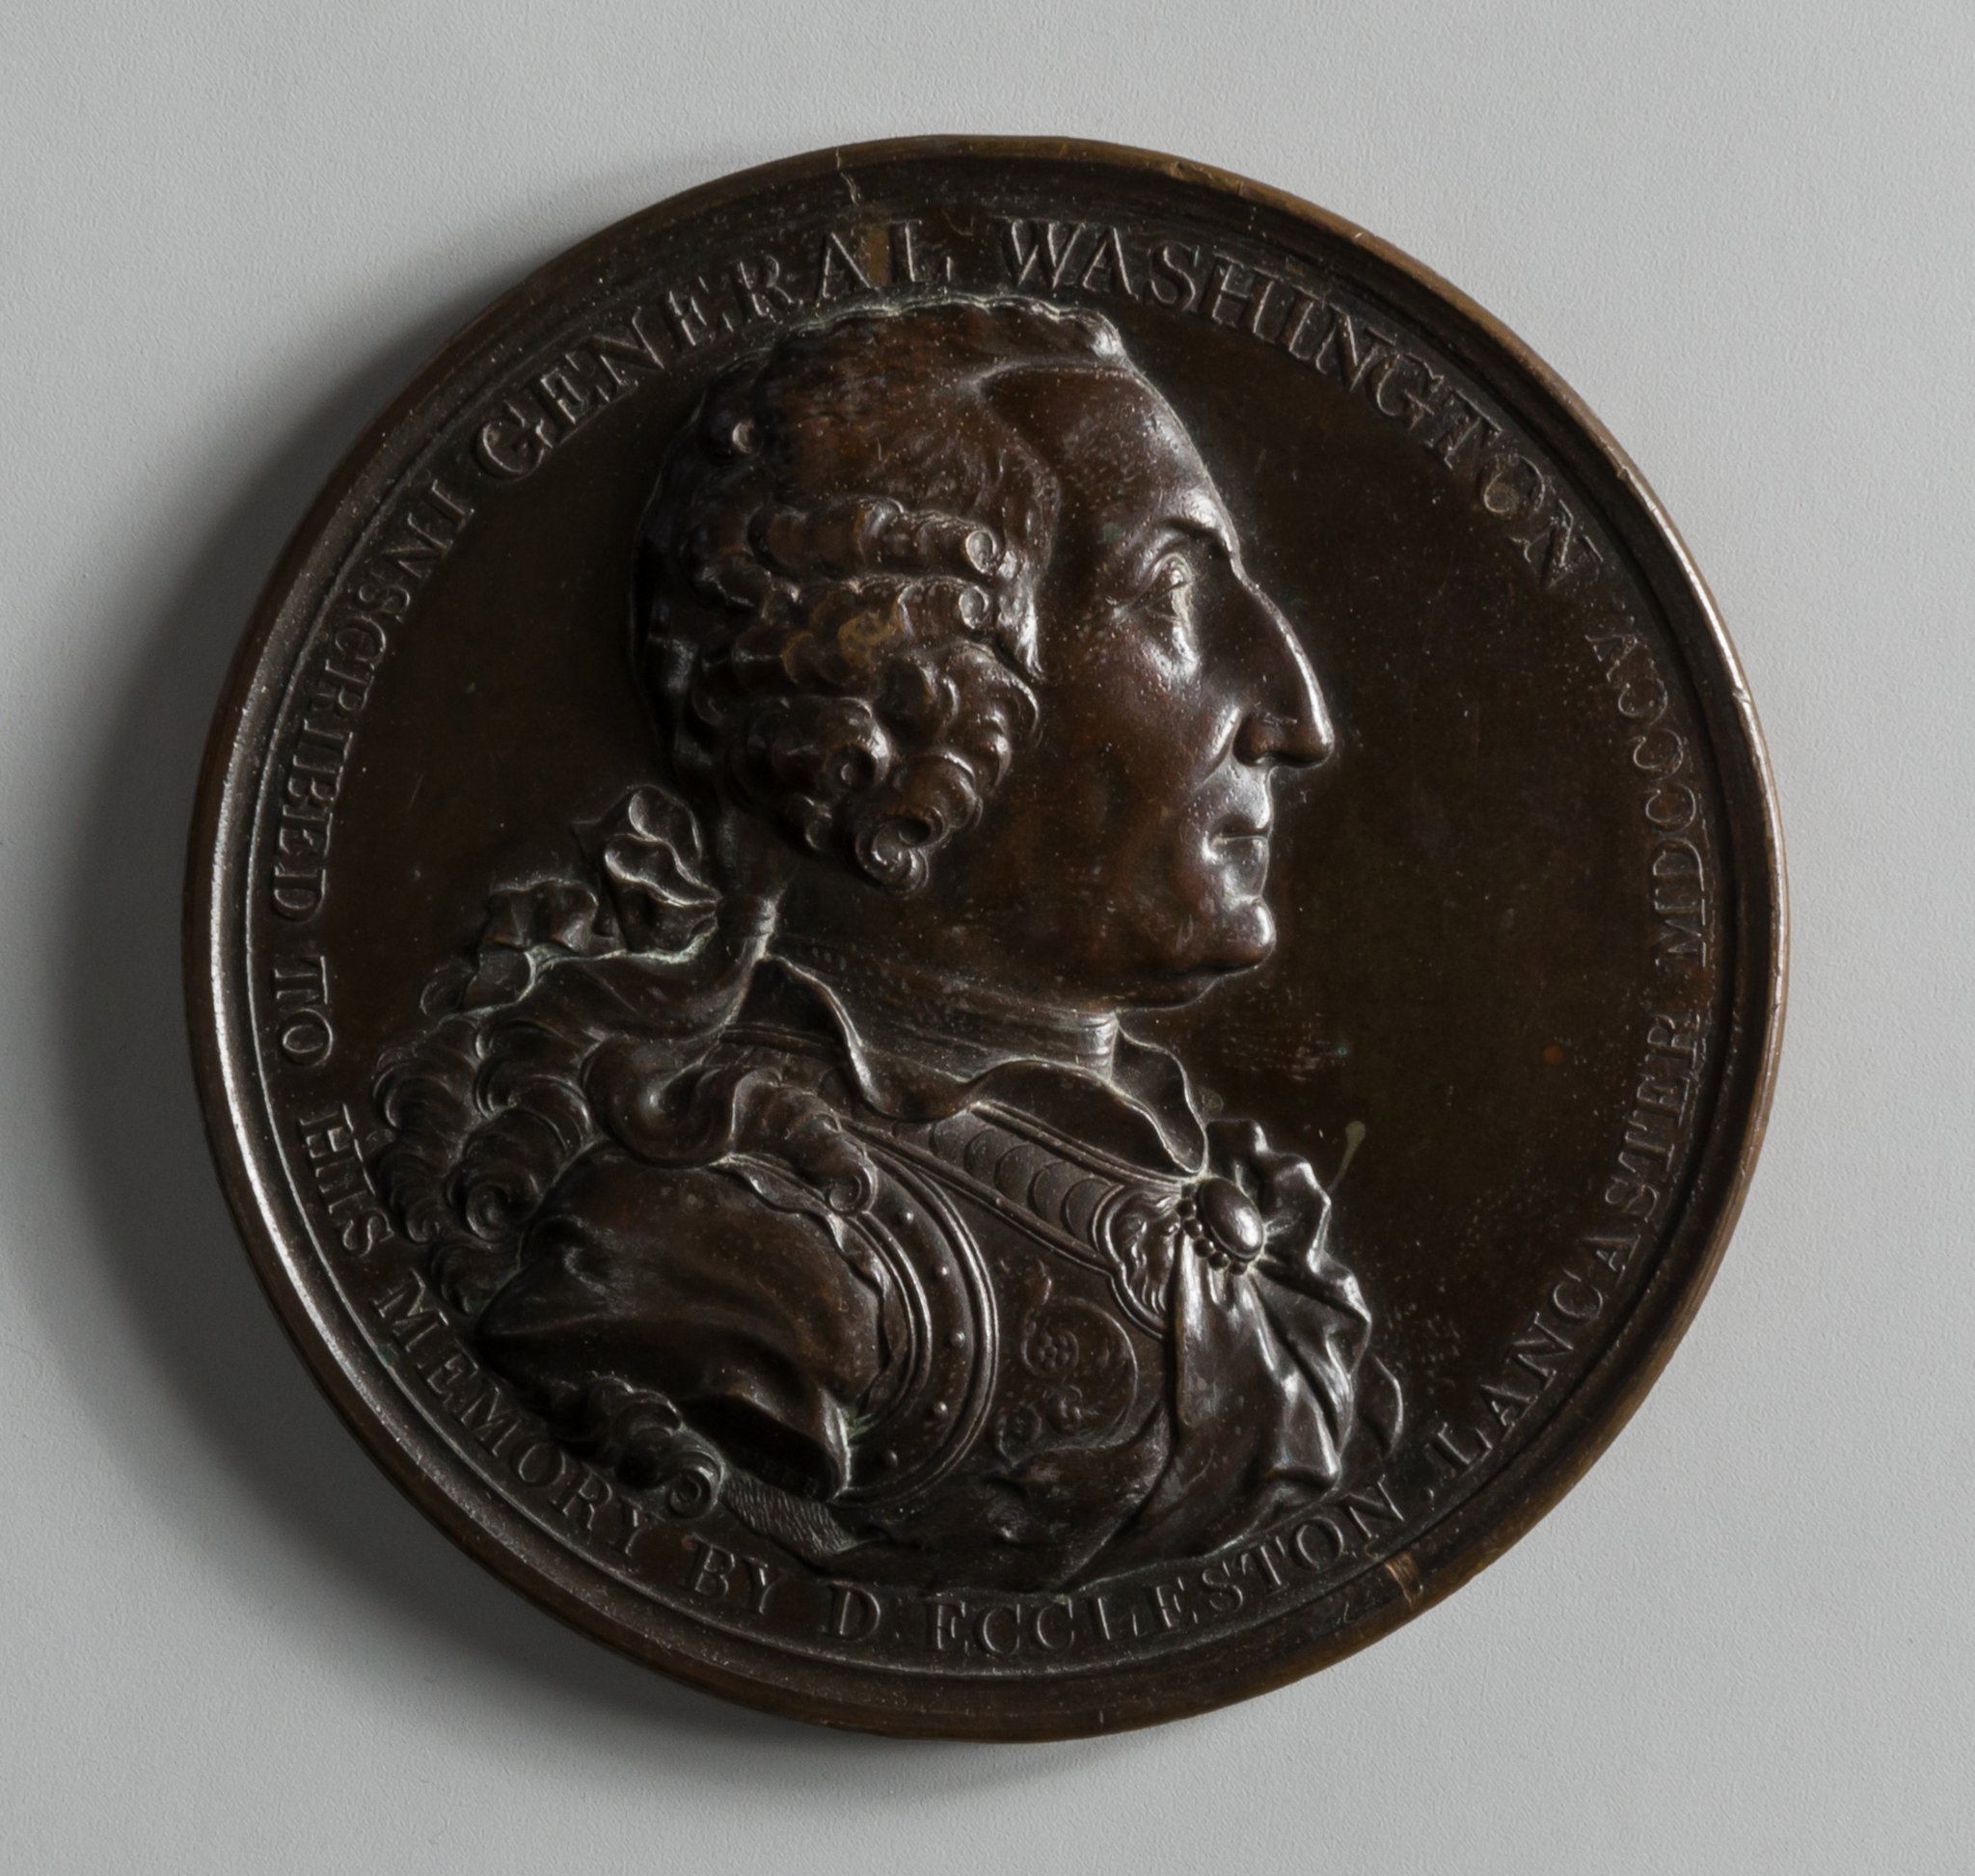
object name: medal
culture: american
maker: webb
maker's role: maker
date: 1805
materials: bronze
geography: united states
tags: men,profiles